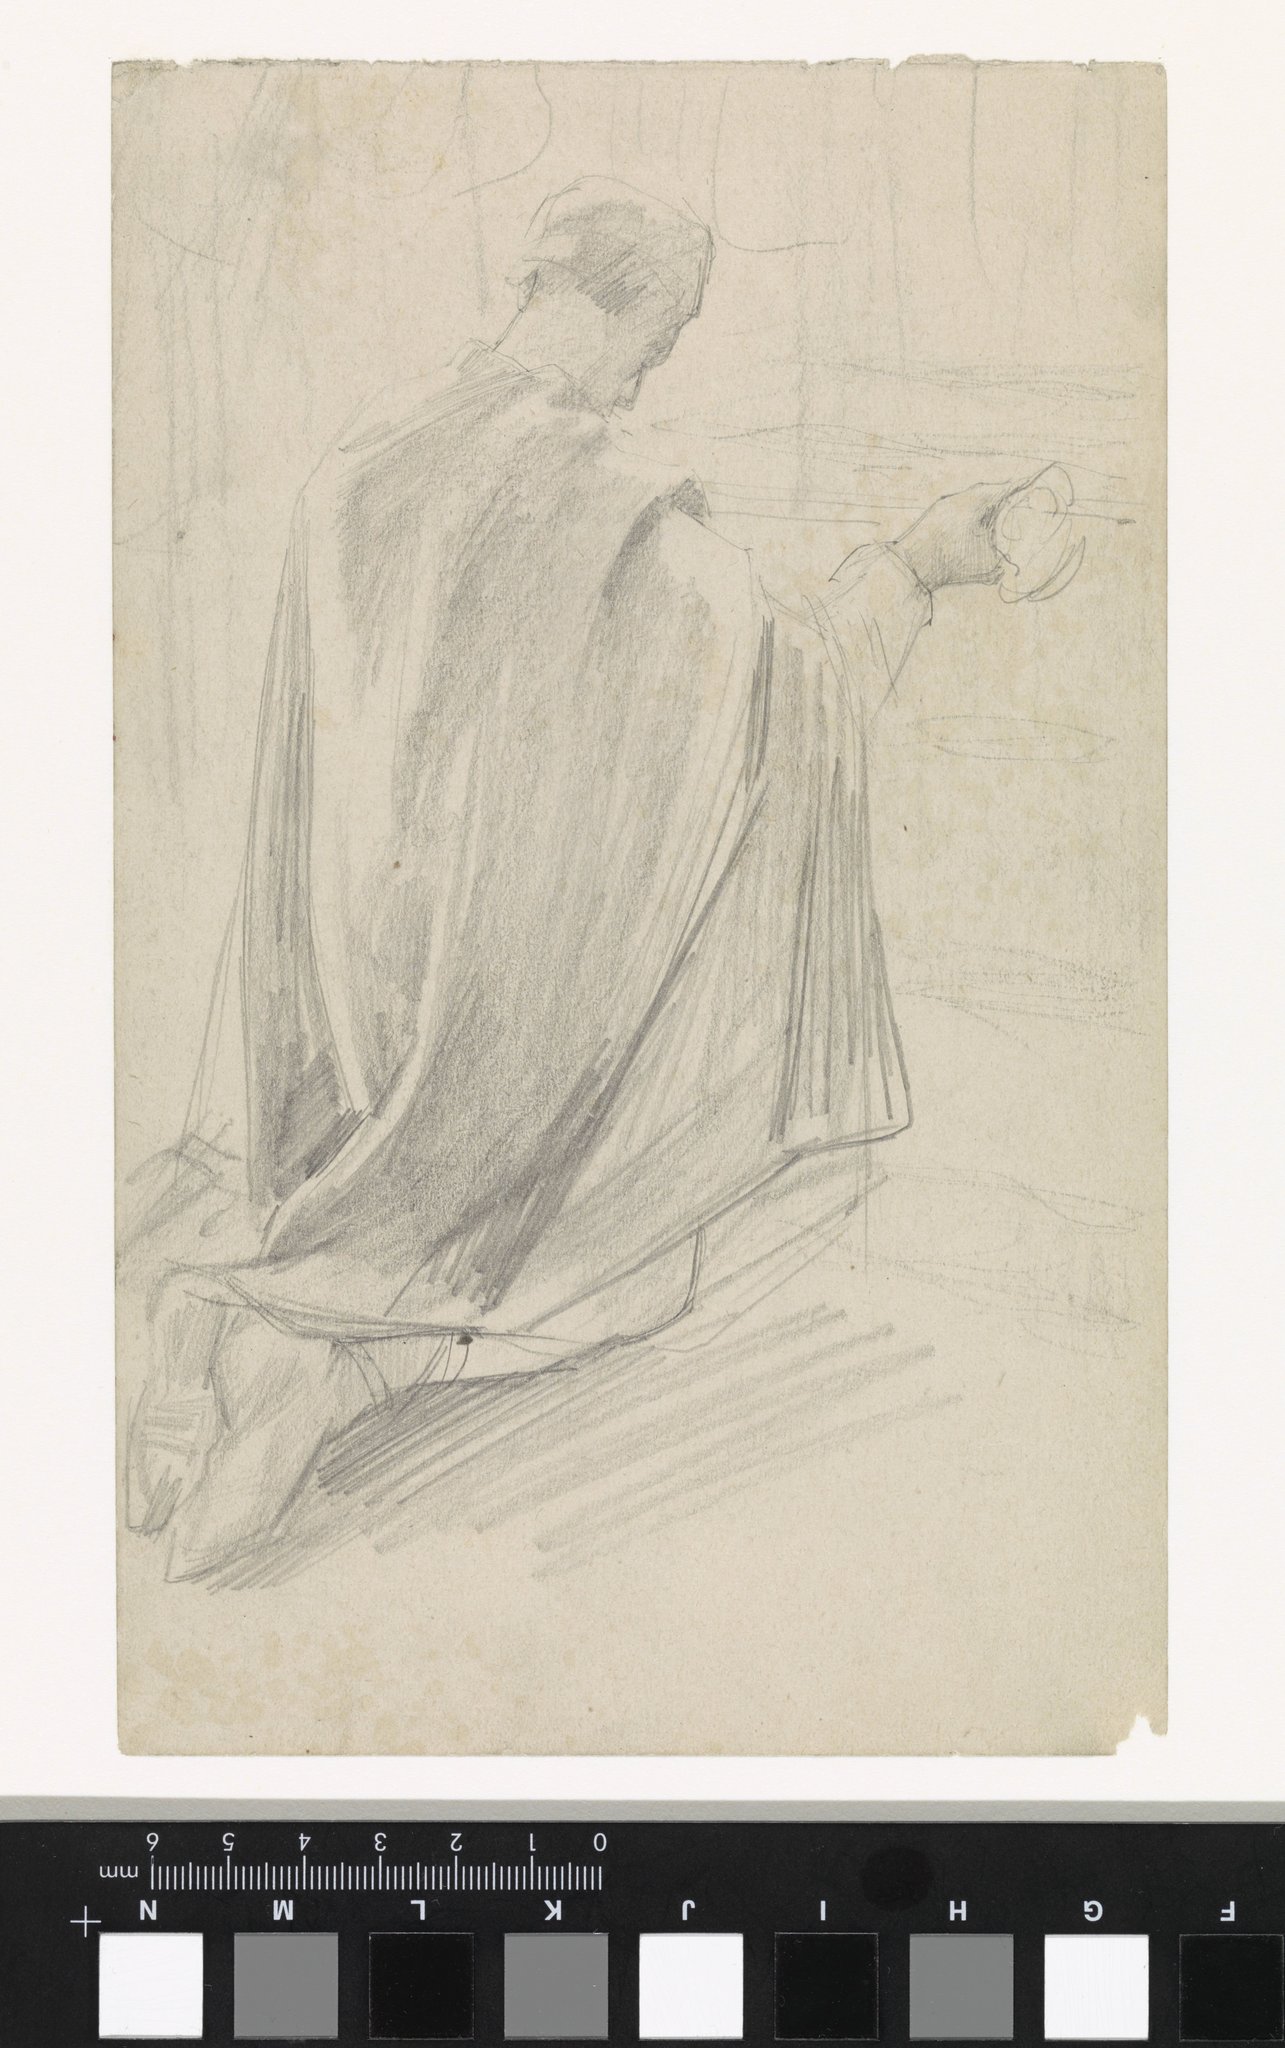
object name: drawing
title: Knielende man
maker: antoon derkinderen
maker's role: draughtsman, painter, print maker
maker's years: 1859-1925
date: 1869-1925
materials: paper, pencil